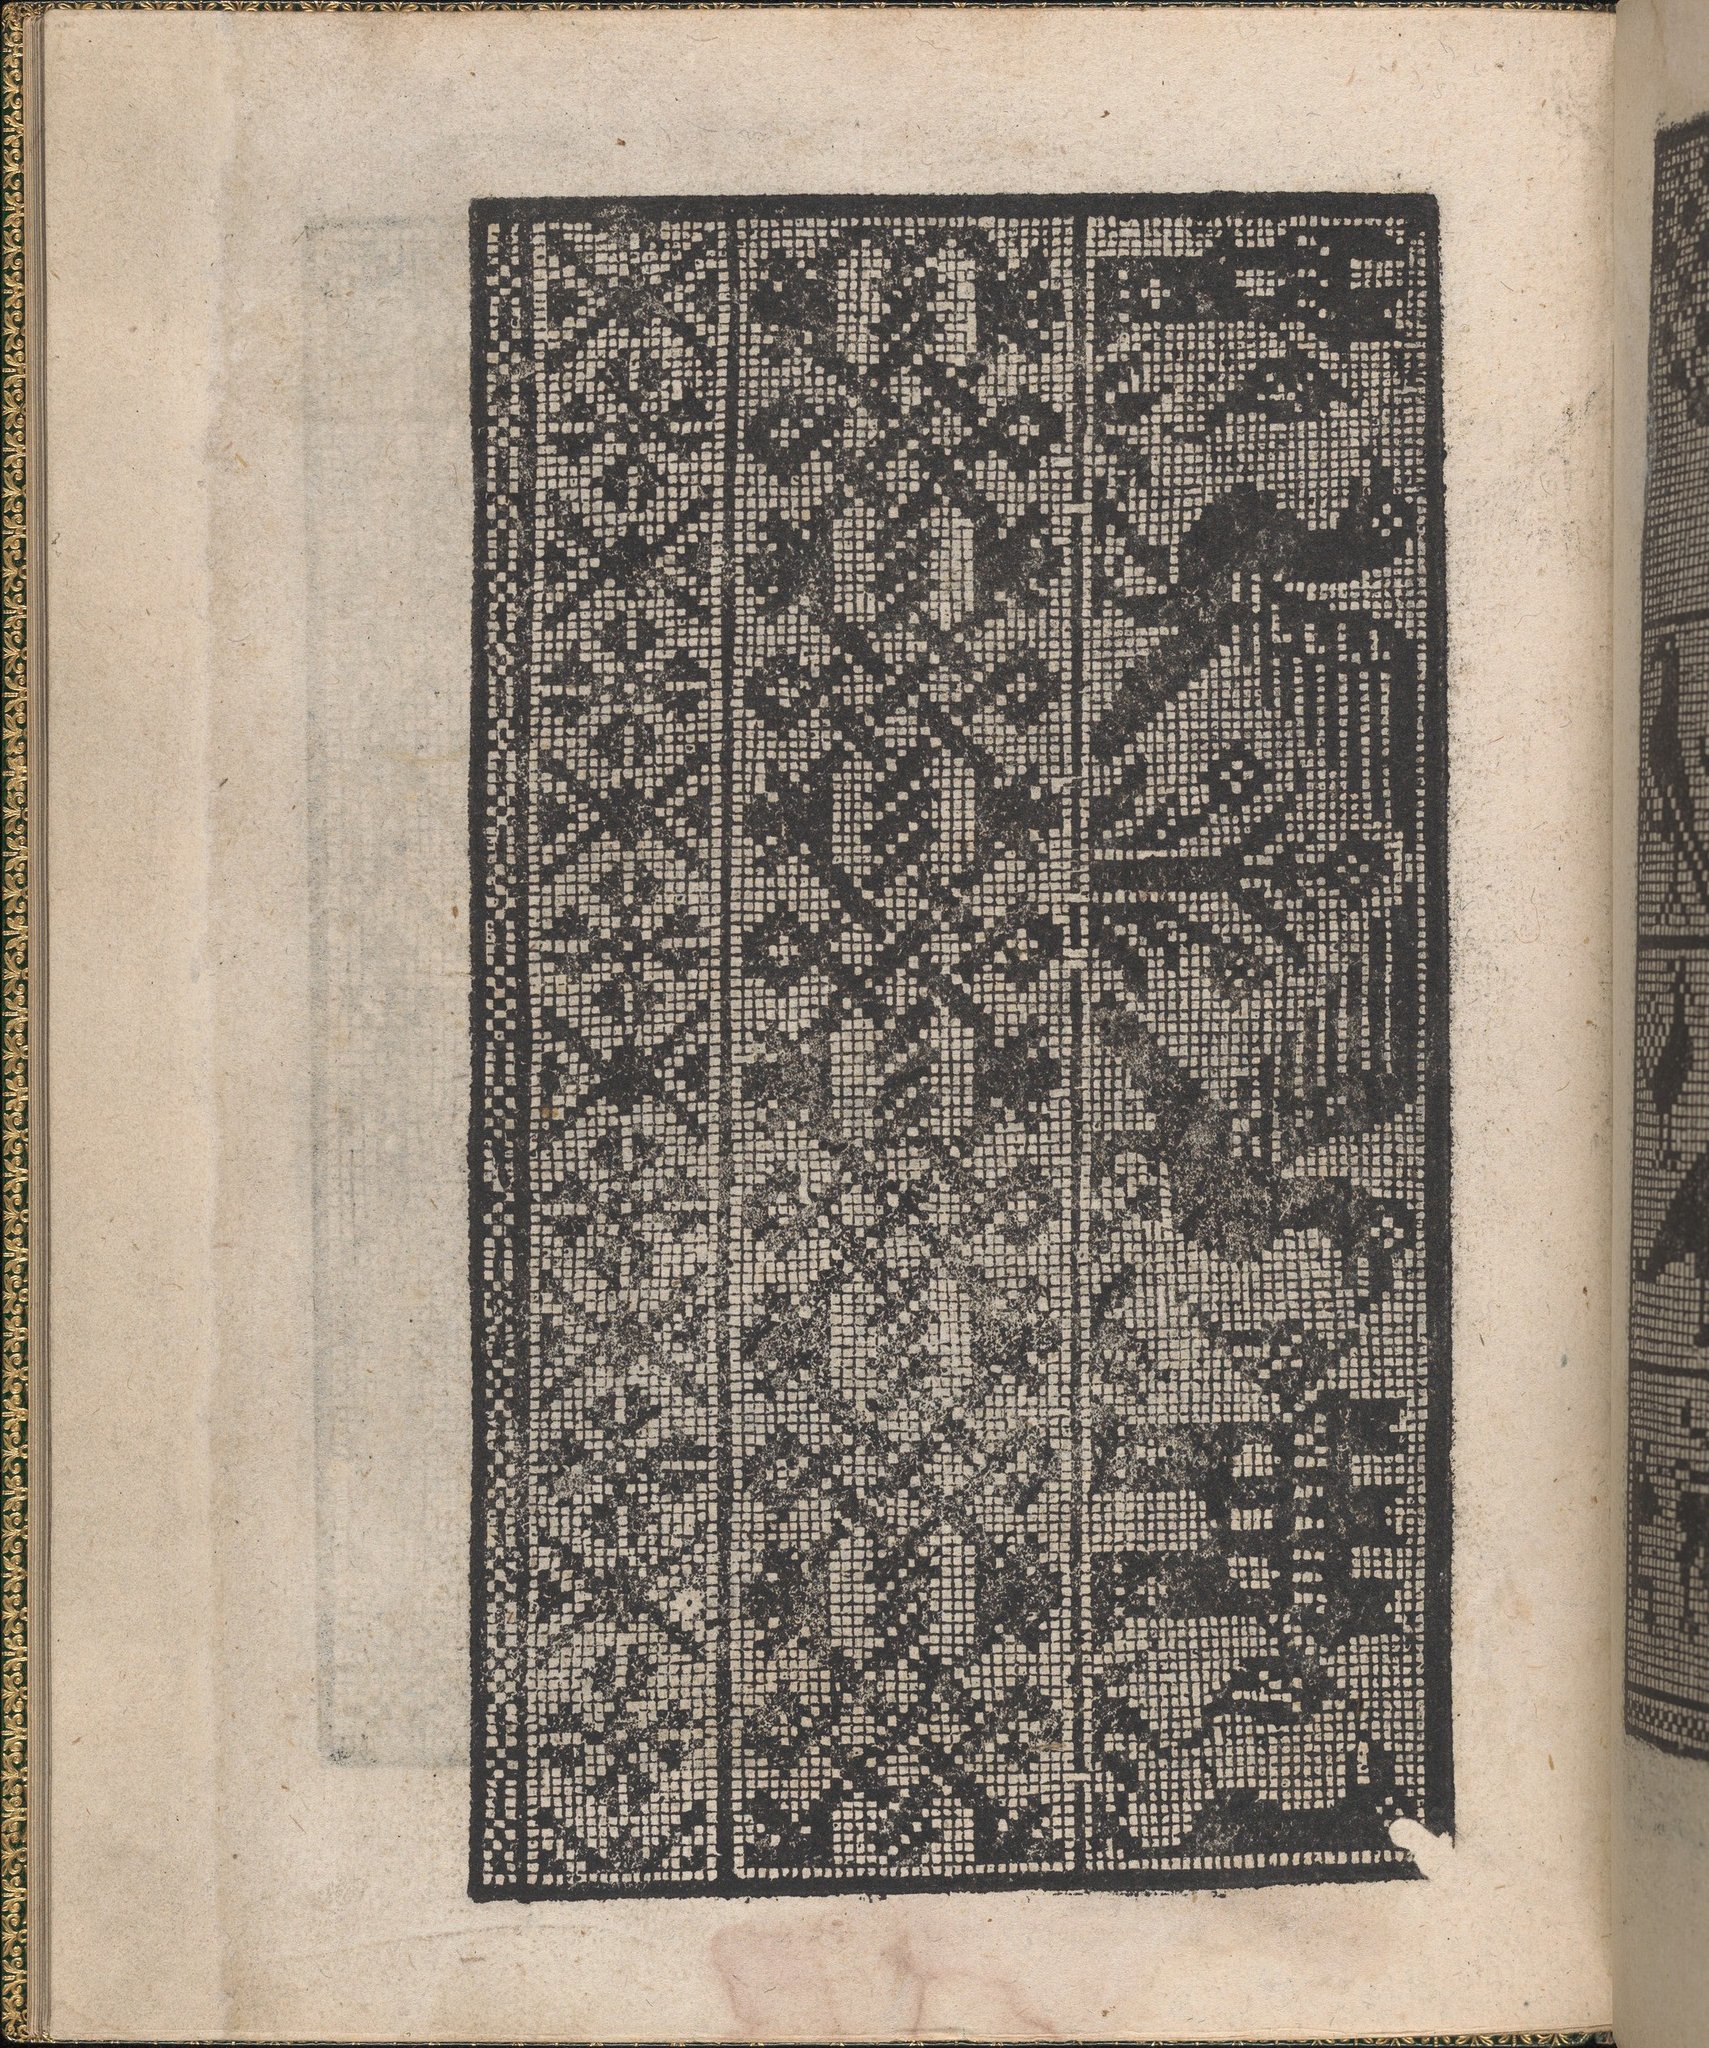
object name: book print ornament architecture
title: Ornamento delle belle & virtuose donne, page 20 (verso)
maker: matteo pagano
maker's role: publisher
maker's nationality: italian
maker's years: 1515-1588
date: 1554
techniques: woodcut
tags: birds